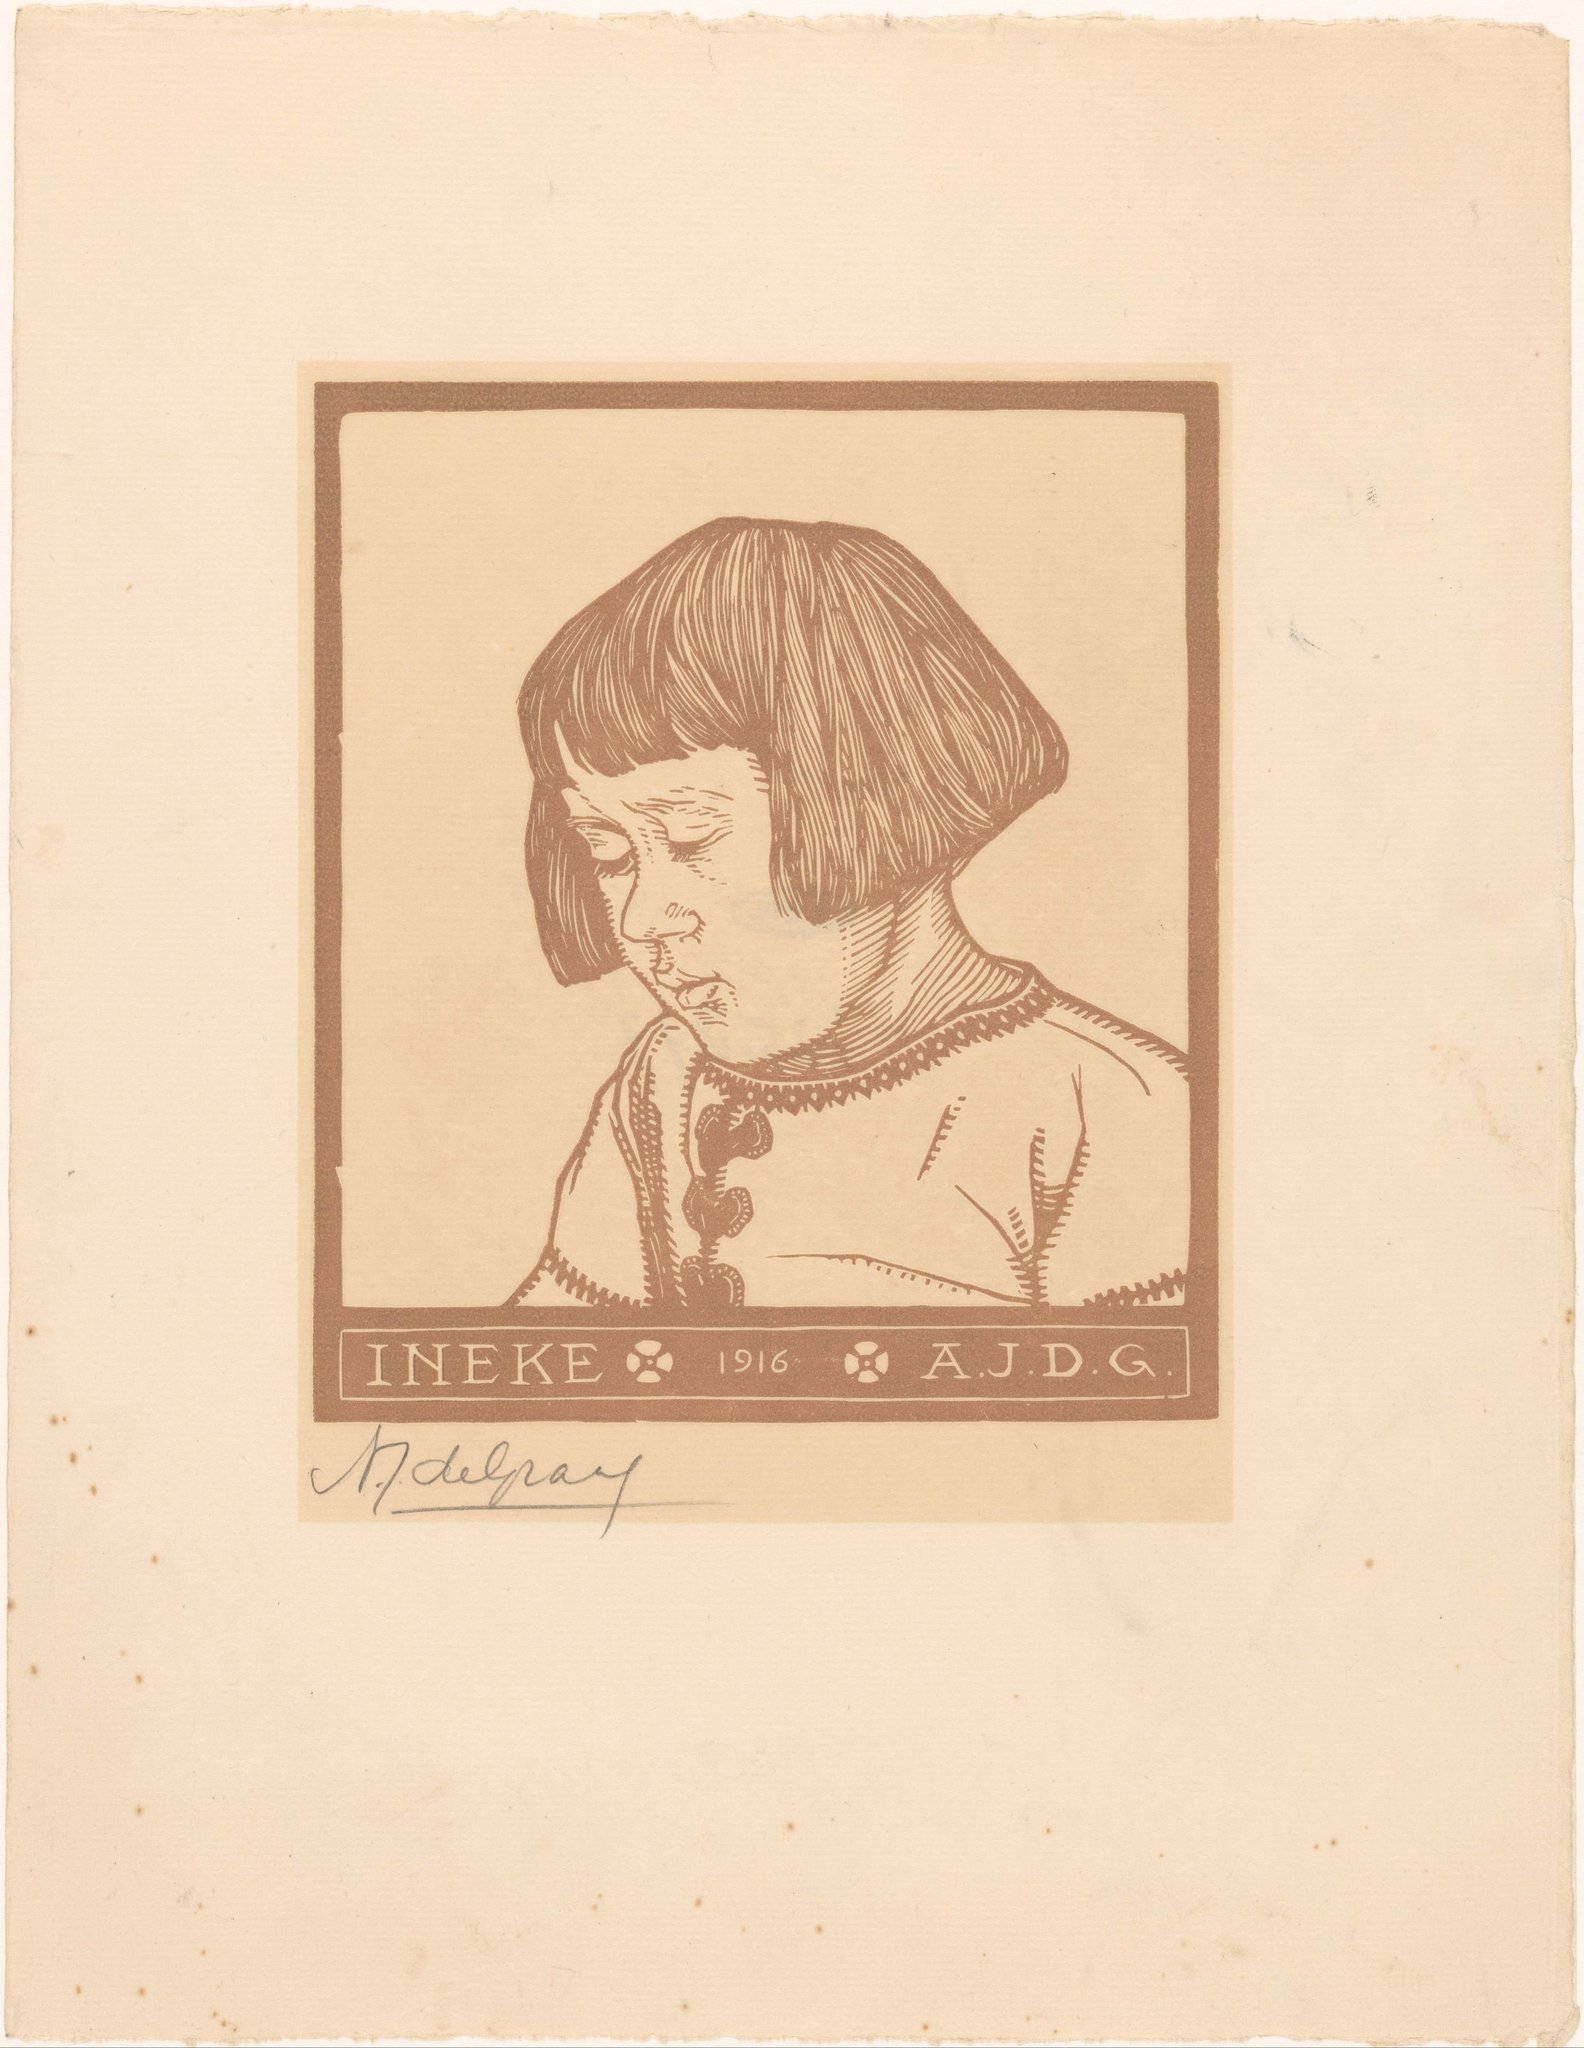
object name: print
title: Portret van Ineke Broekman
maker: julie de graag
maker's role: draughtsman, print maker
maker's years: 1877-1924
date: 1916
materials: paper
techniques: woodcut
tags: historical persons - bb - woman, girl (child between toddler and youth)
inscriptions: collector's mark: Lugt 2228